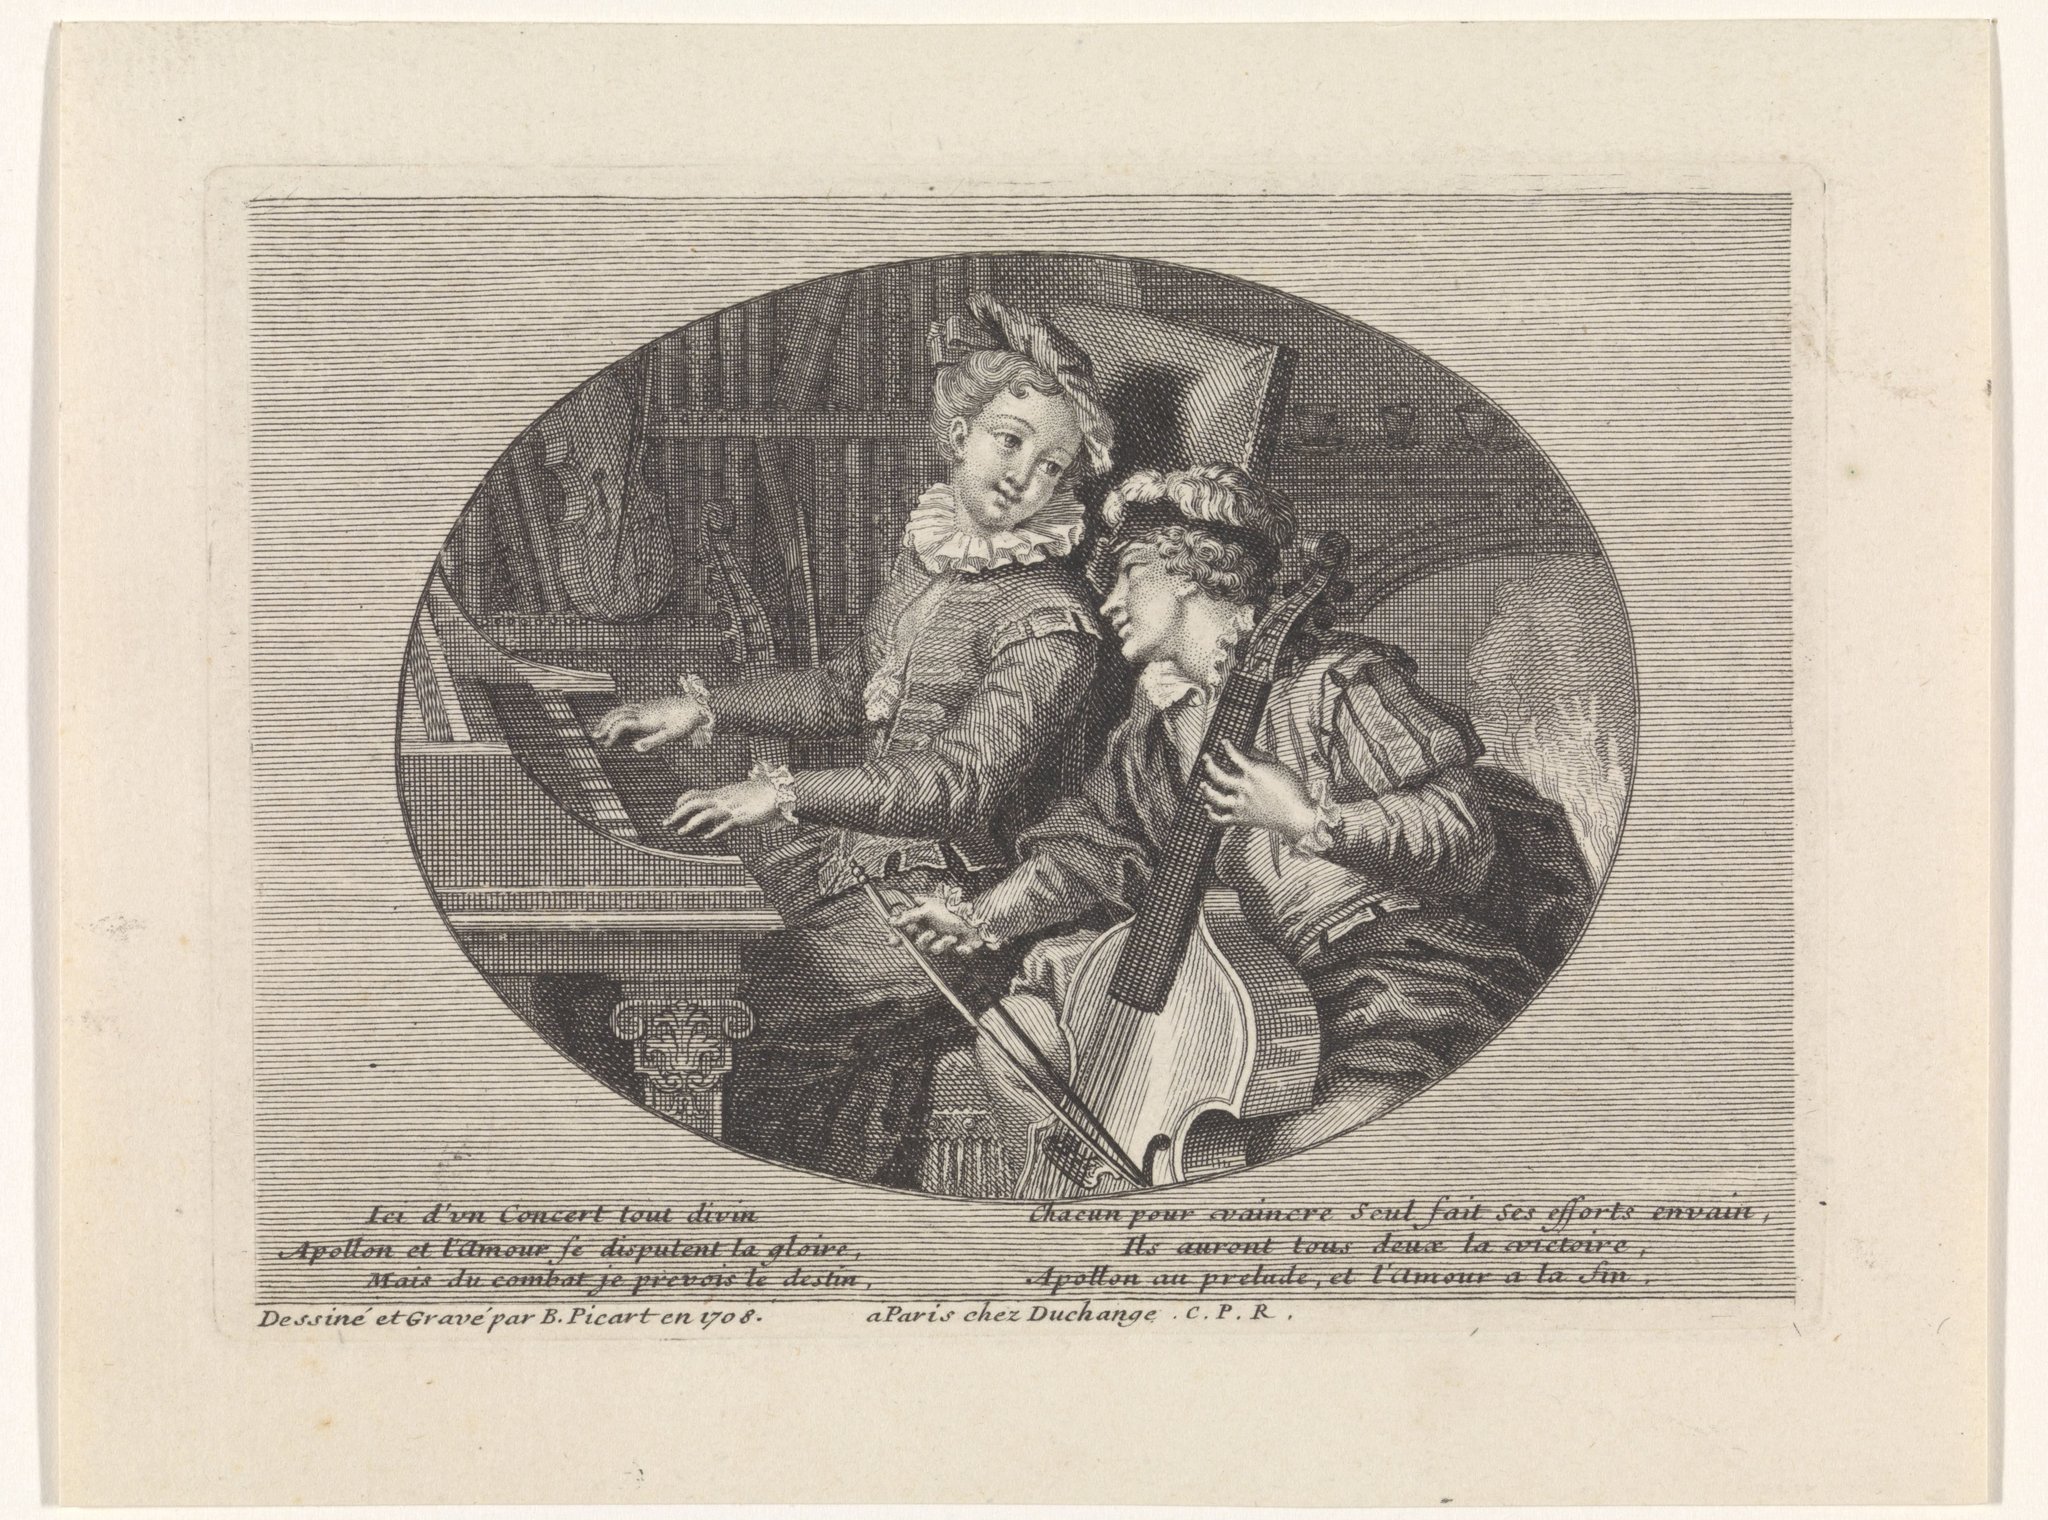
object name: print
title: Musicerend paar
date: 1708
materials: paper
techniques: engraving, etching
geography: paris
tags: open hearth, fire-place, more than one musician with instrument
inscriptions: collector's mark: Lugt 2228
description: Interieur met een jong paar dat bij een brandend haardvuur muziek maakt. De vrouw bespeelt de piano en de man een bas. In de marge een zesregelig gedicht in het Frans.